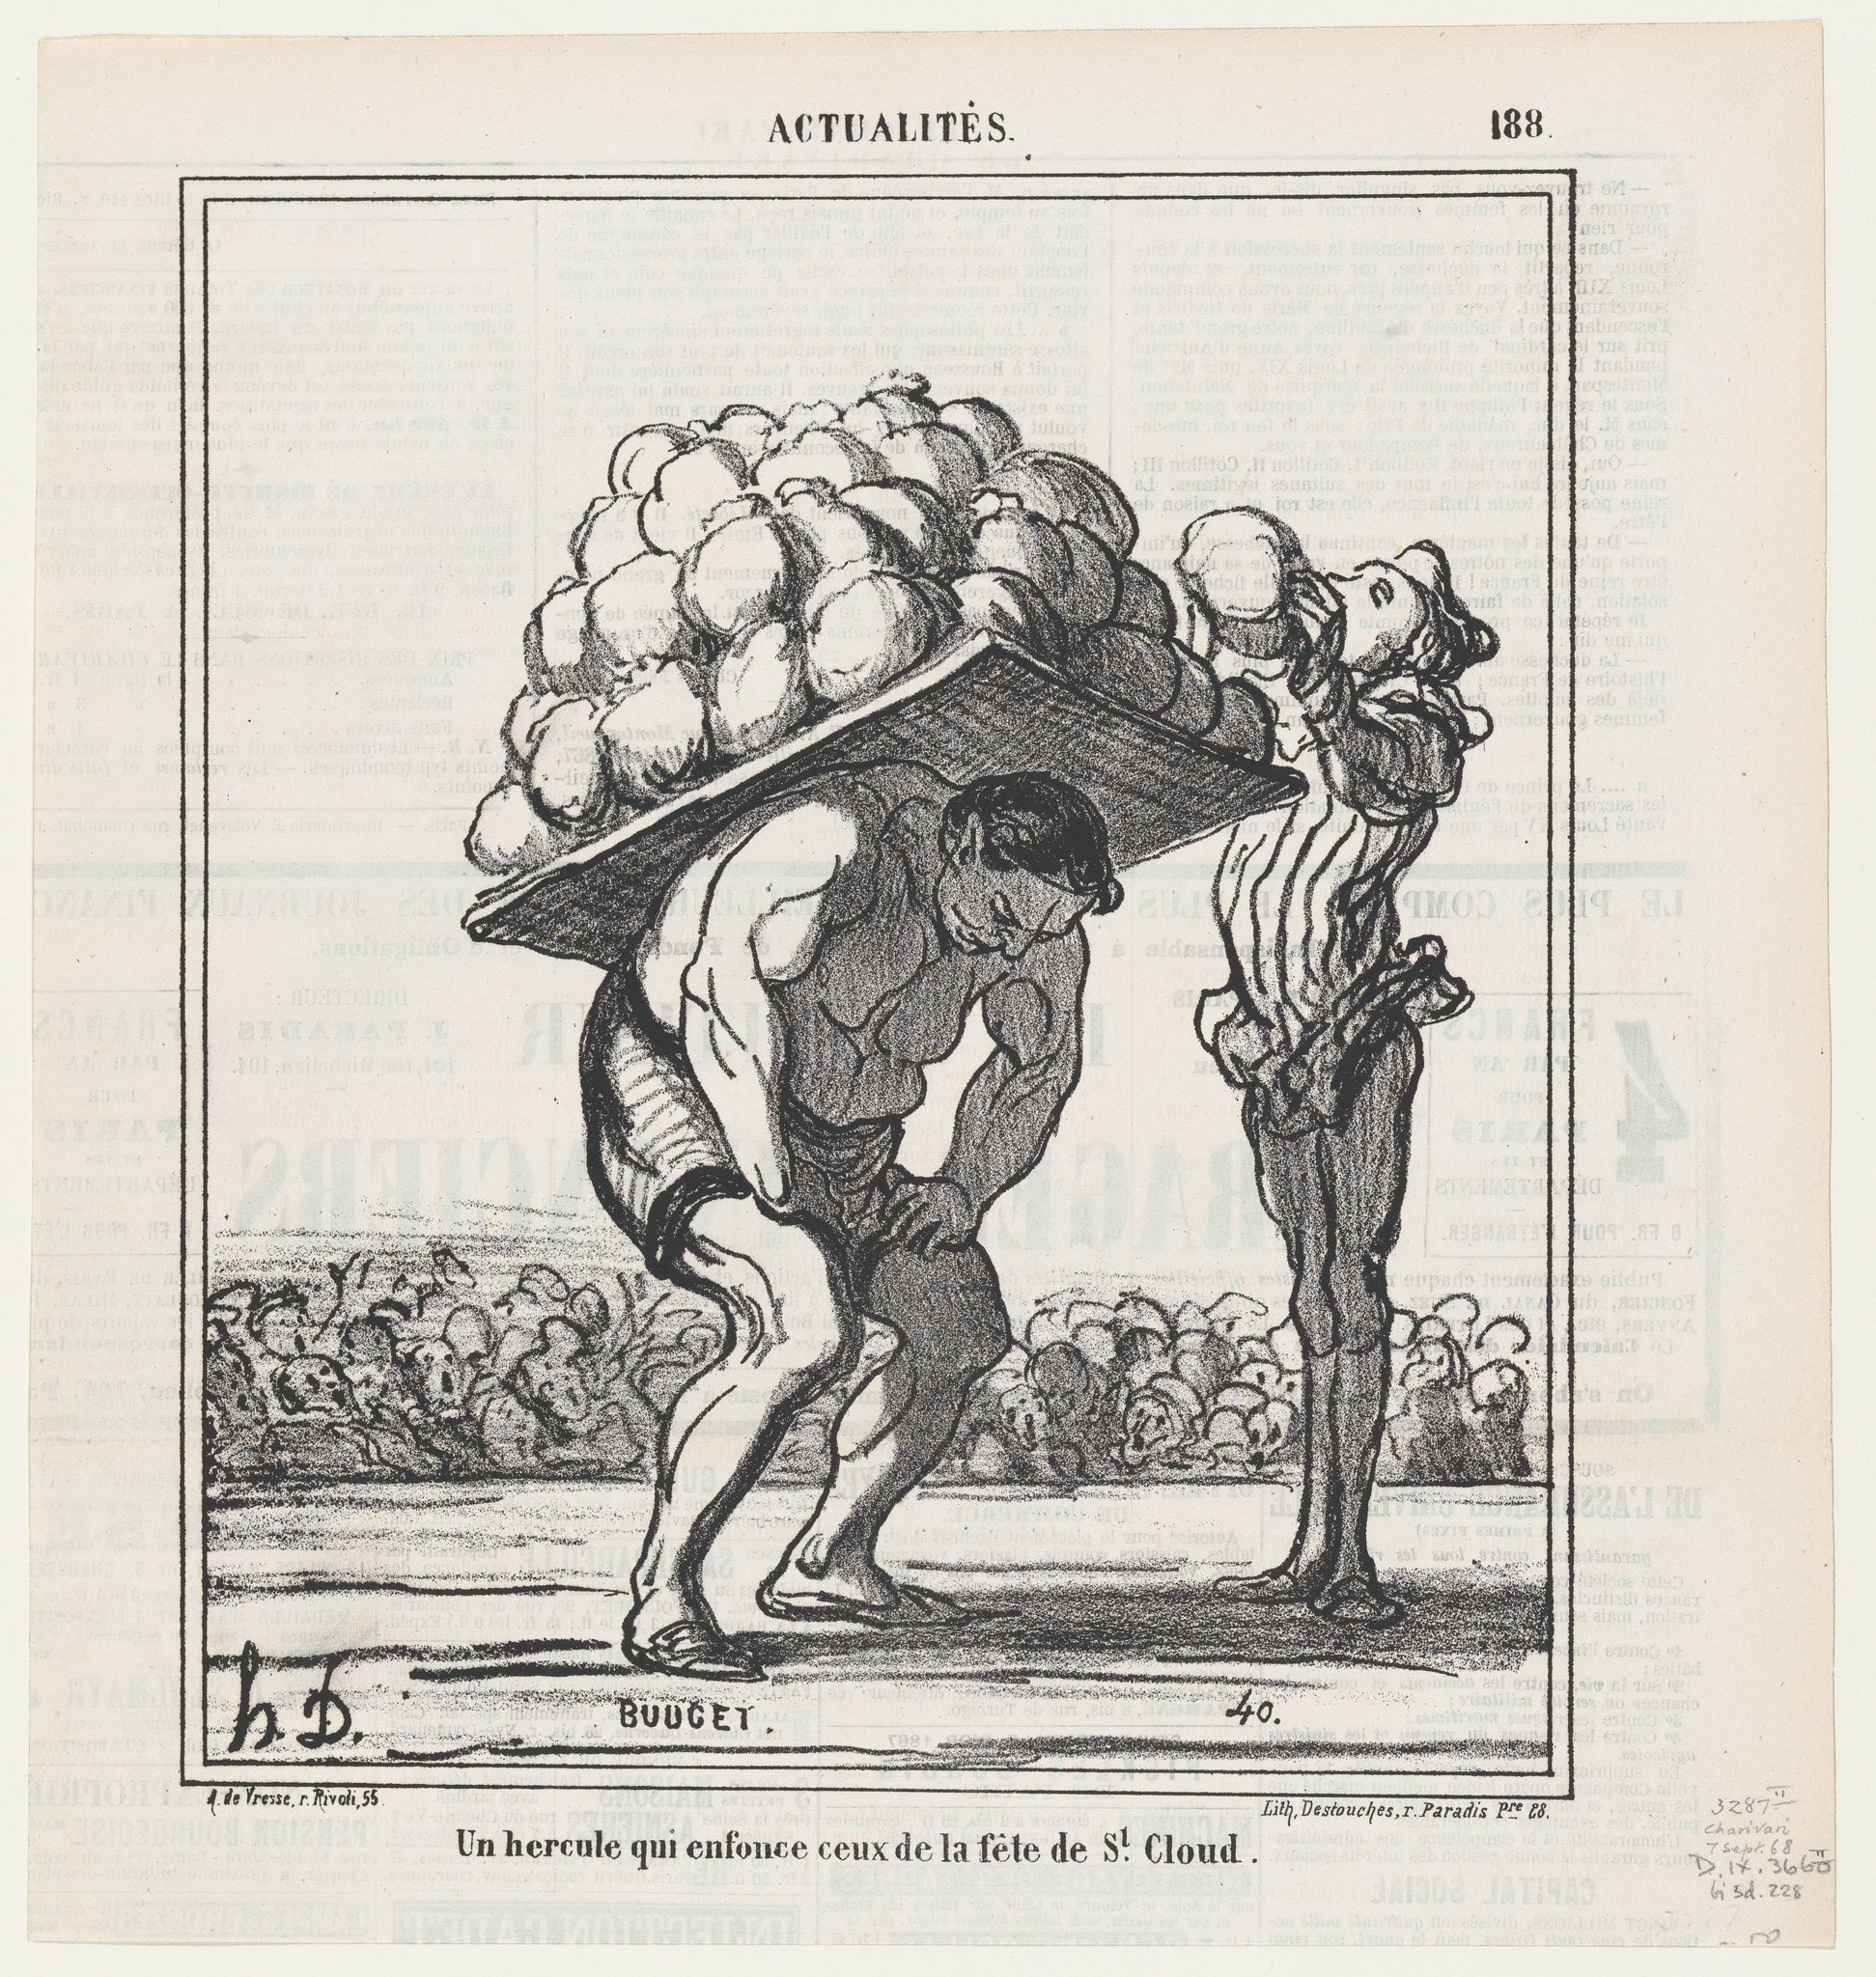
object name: print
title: A Hercules who even beats those at the Saint-Cloud Fair, from 'News of the day,' published in Le Charivari, September 7, 1868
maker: honoré daumier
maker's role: artist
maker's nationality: french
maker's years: 1808-1879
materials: paper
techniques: lithograph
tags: men,working